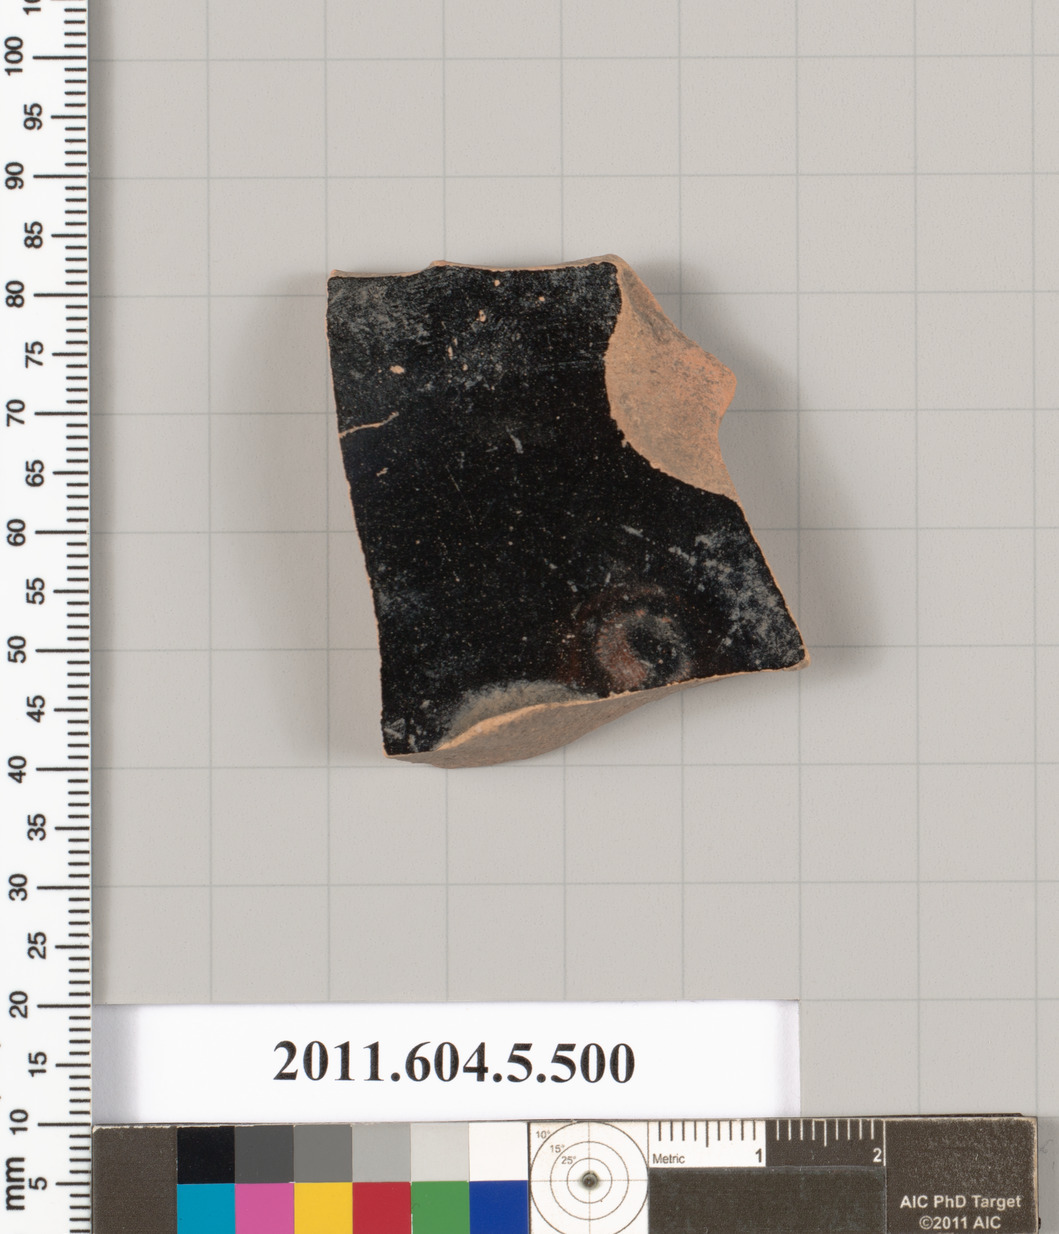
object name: kylix fragment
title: Terracotta fragment of a kylix (drinking cup)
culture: greek, attic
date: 600-401 BCE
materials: terracotta